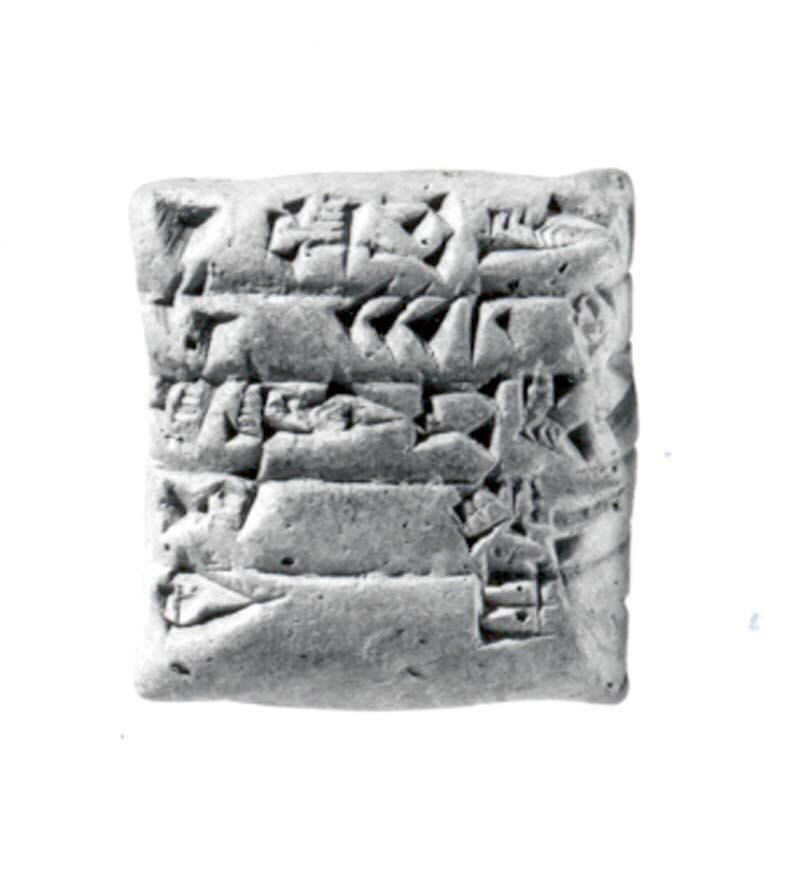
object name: cuneiform tablet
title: Cuneiform tablet: receipt of a kid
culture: neo-sumerian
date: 2039 BCE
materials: clay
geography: mesopotamia